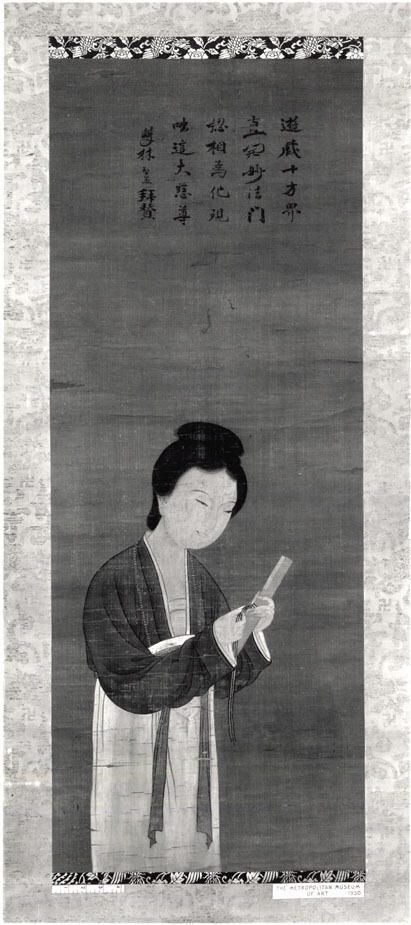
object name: hanging scroll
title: Lady with Scroll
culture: chinese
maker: unidentified artist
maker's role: artist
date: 1368-1911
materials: silk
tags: scrolls,women